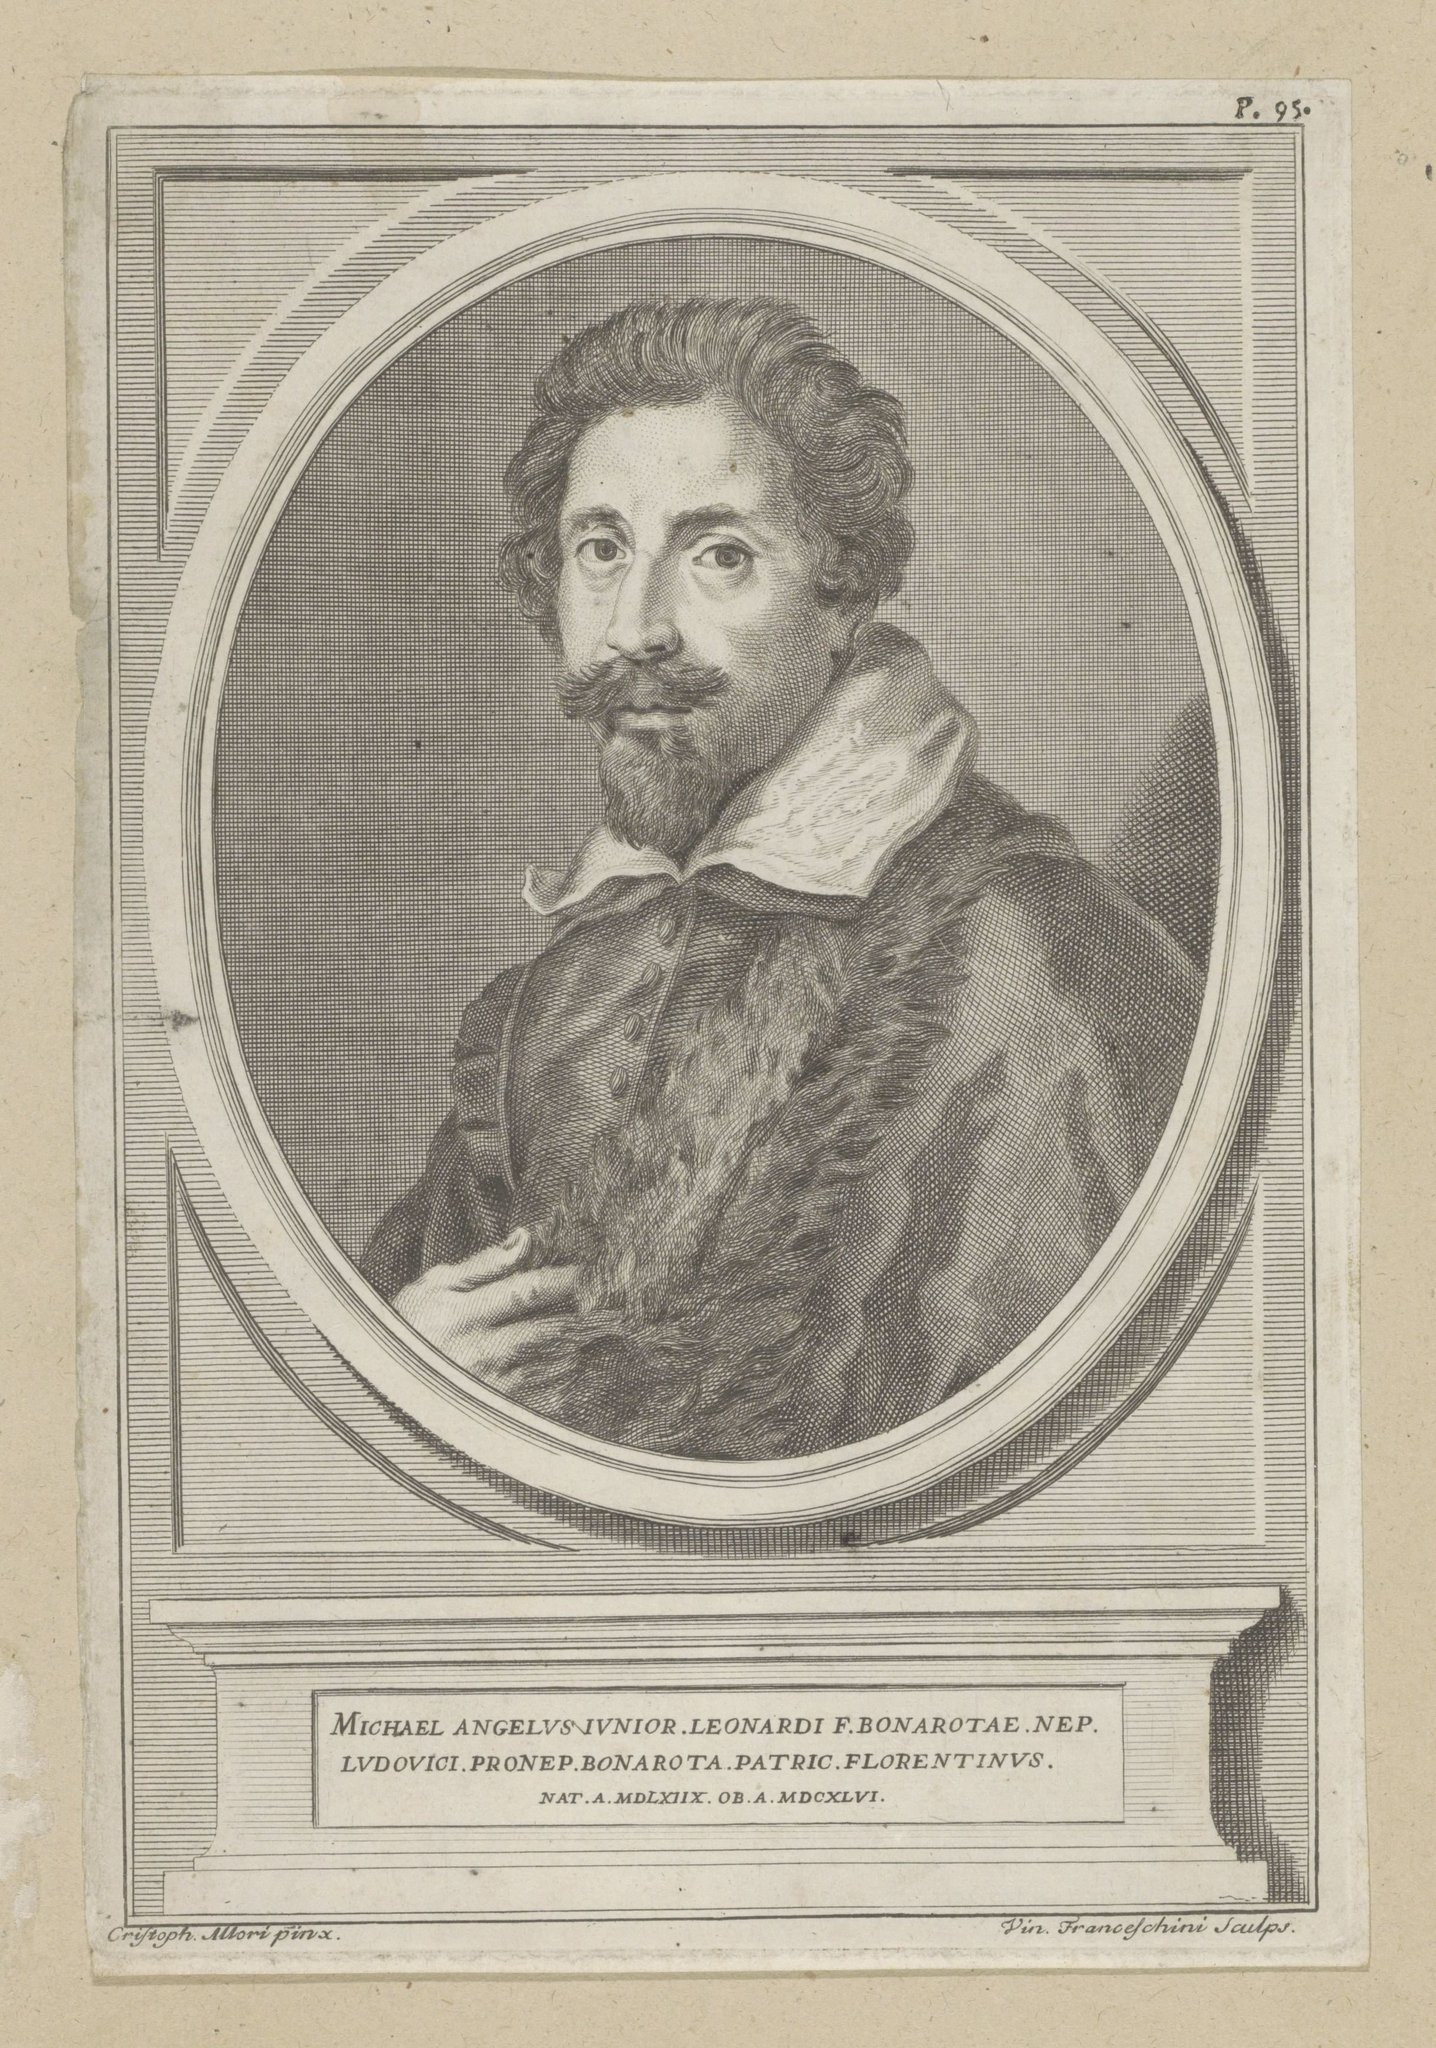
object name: print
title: Portret van kunstenaar Michelangelo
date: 1690-1750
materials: paper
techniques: etching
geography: florence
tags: rome, painter, draughtsman, sculptor, michelangelo, historical persons, portrait, self-portrait of artist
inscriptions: collector's mark: Lugt 2228